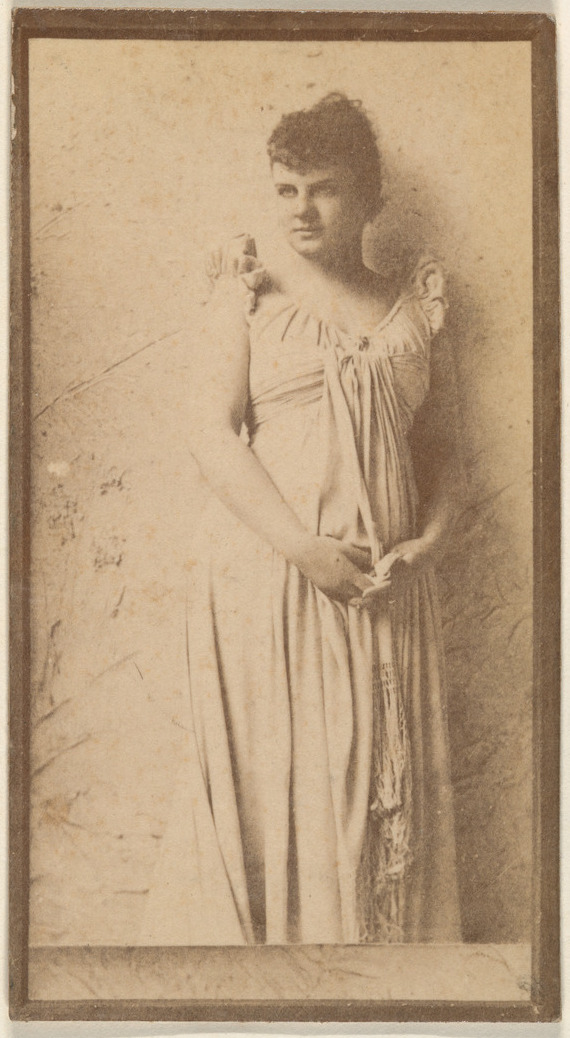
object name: photograph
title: Standing actress in simple white gown, from the Actresses series (N668)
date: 1888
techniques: albumen silver print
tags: portraits,women,actresses